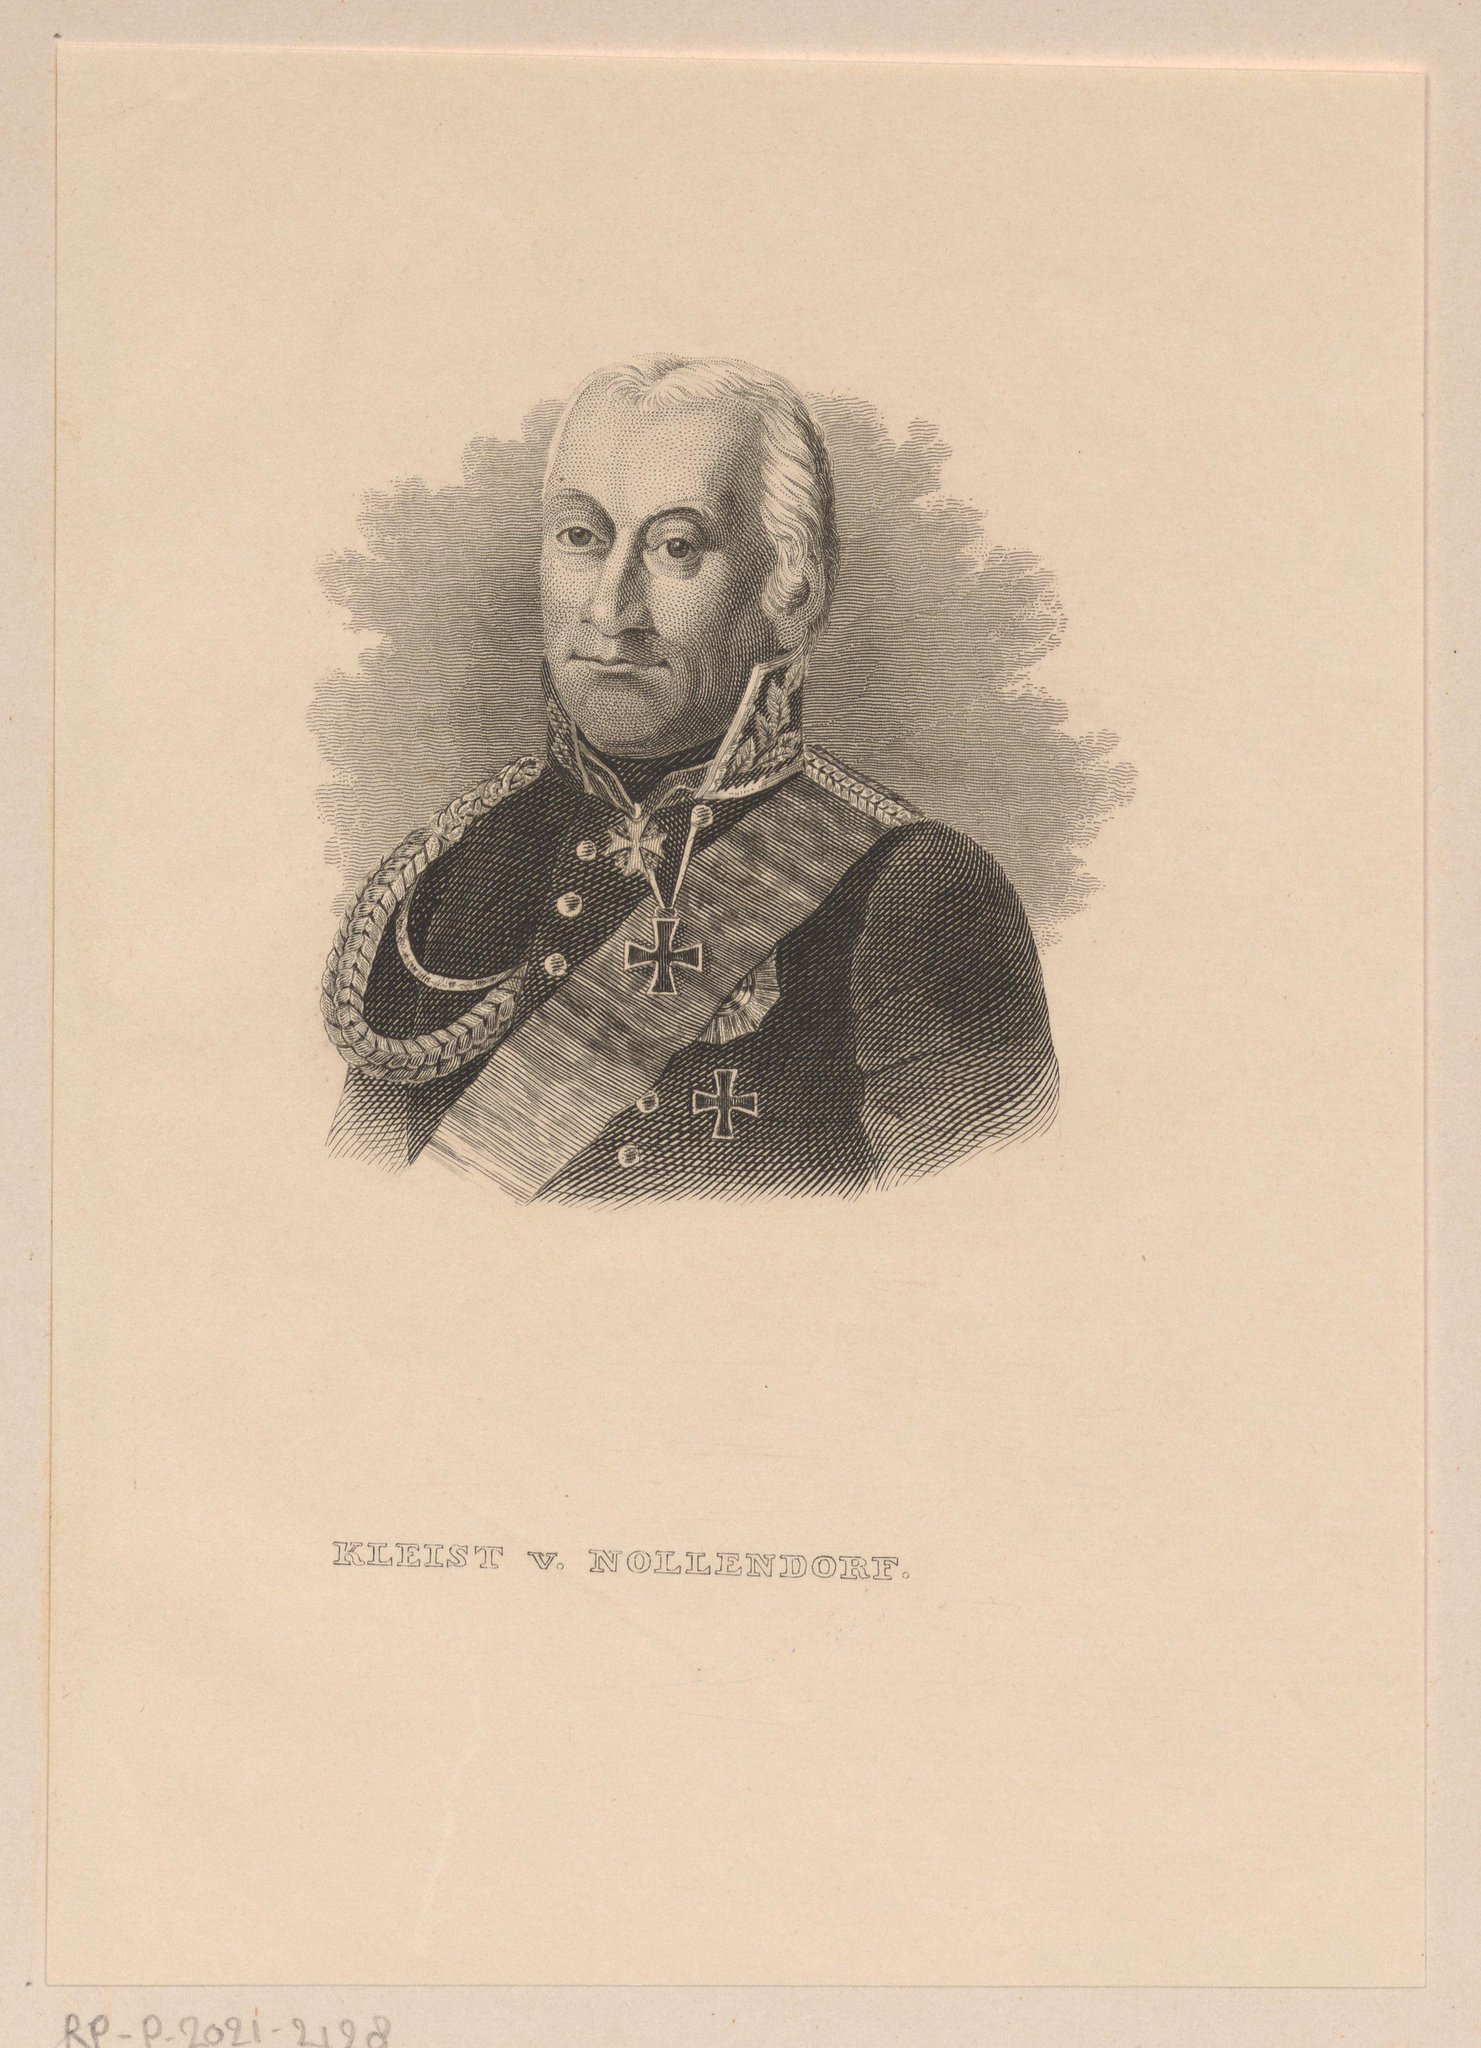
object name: print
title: Portret van Friedrich Heinrich Ferdinand Emil Kleist von Nollendorf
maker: georg westermann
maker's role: printer, publisher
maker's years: 1810-1879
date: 1838-1879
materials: paper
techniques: engraving, etching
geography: braunschweig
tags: berlin, historical persons